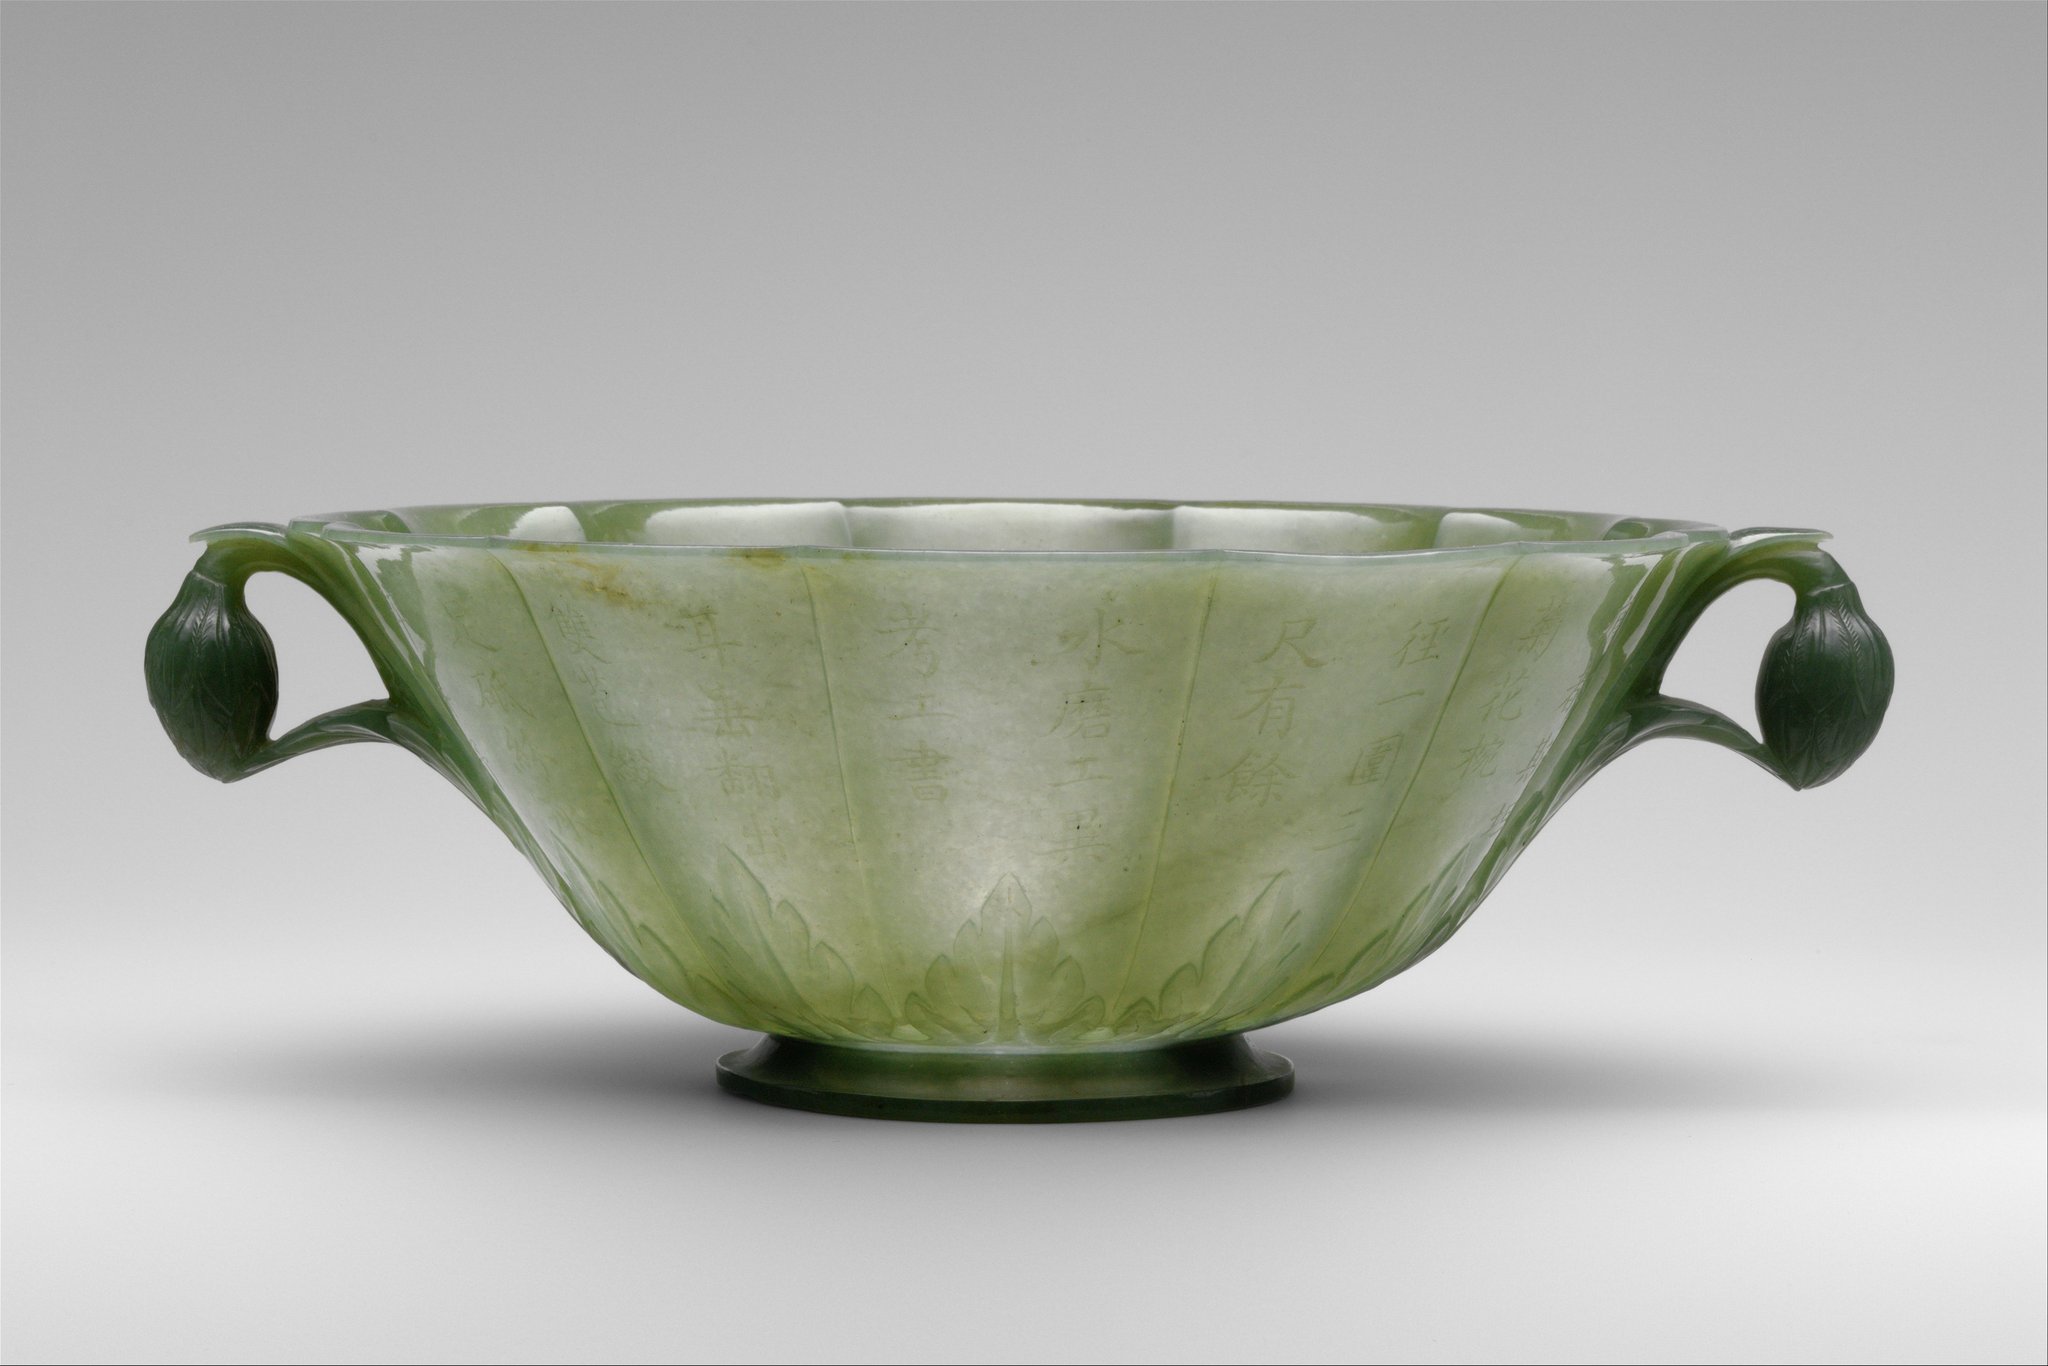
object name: bowl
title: Bowl in the shape of a chrysanthemum flower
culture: indian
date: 1701-1800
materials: jade